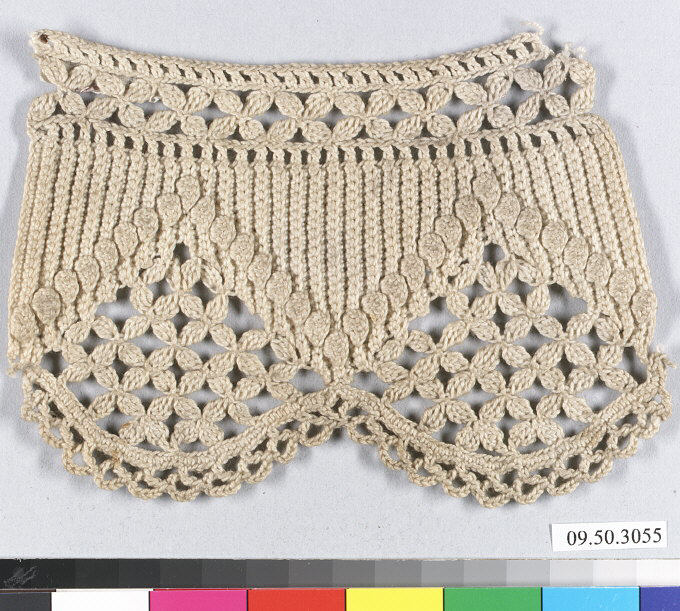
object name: sample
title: Crochet Work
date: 1801-1900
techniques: crochet